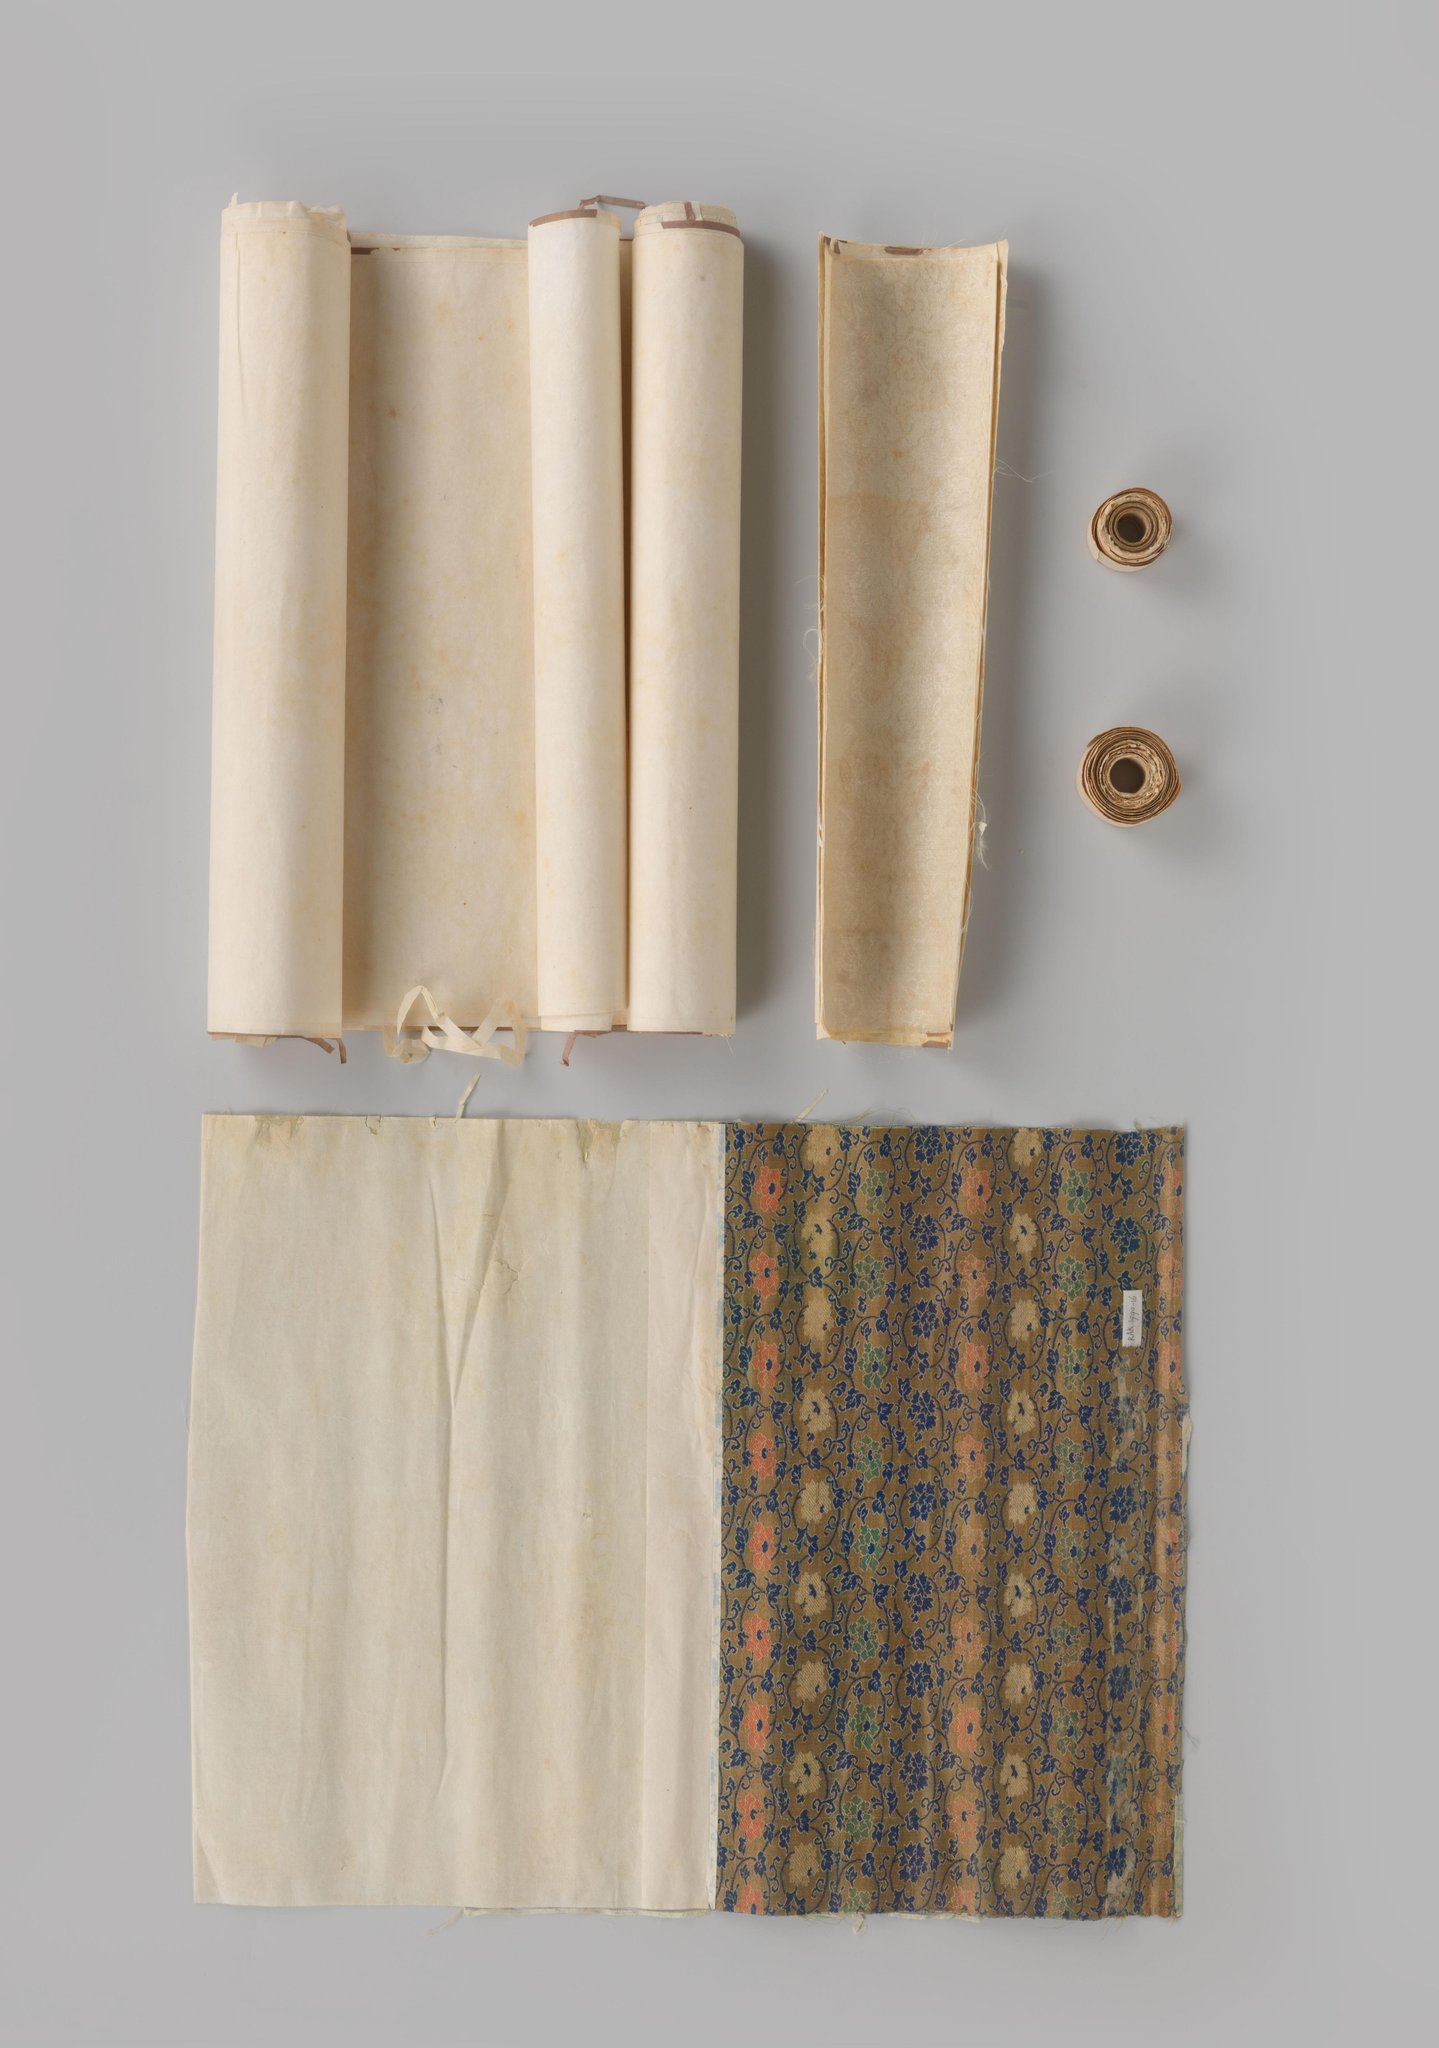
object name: passe partout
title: Passe partout voor handrol, twee ambtenaren met gevolg op reis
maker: zhu henian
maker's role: painter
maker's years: 1760-1834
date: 1803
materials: ink, paper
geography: jiangsu